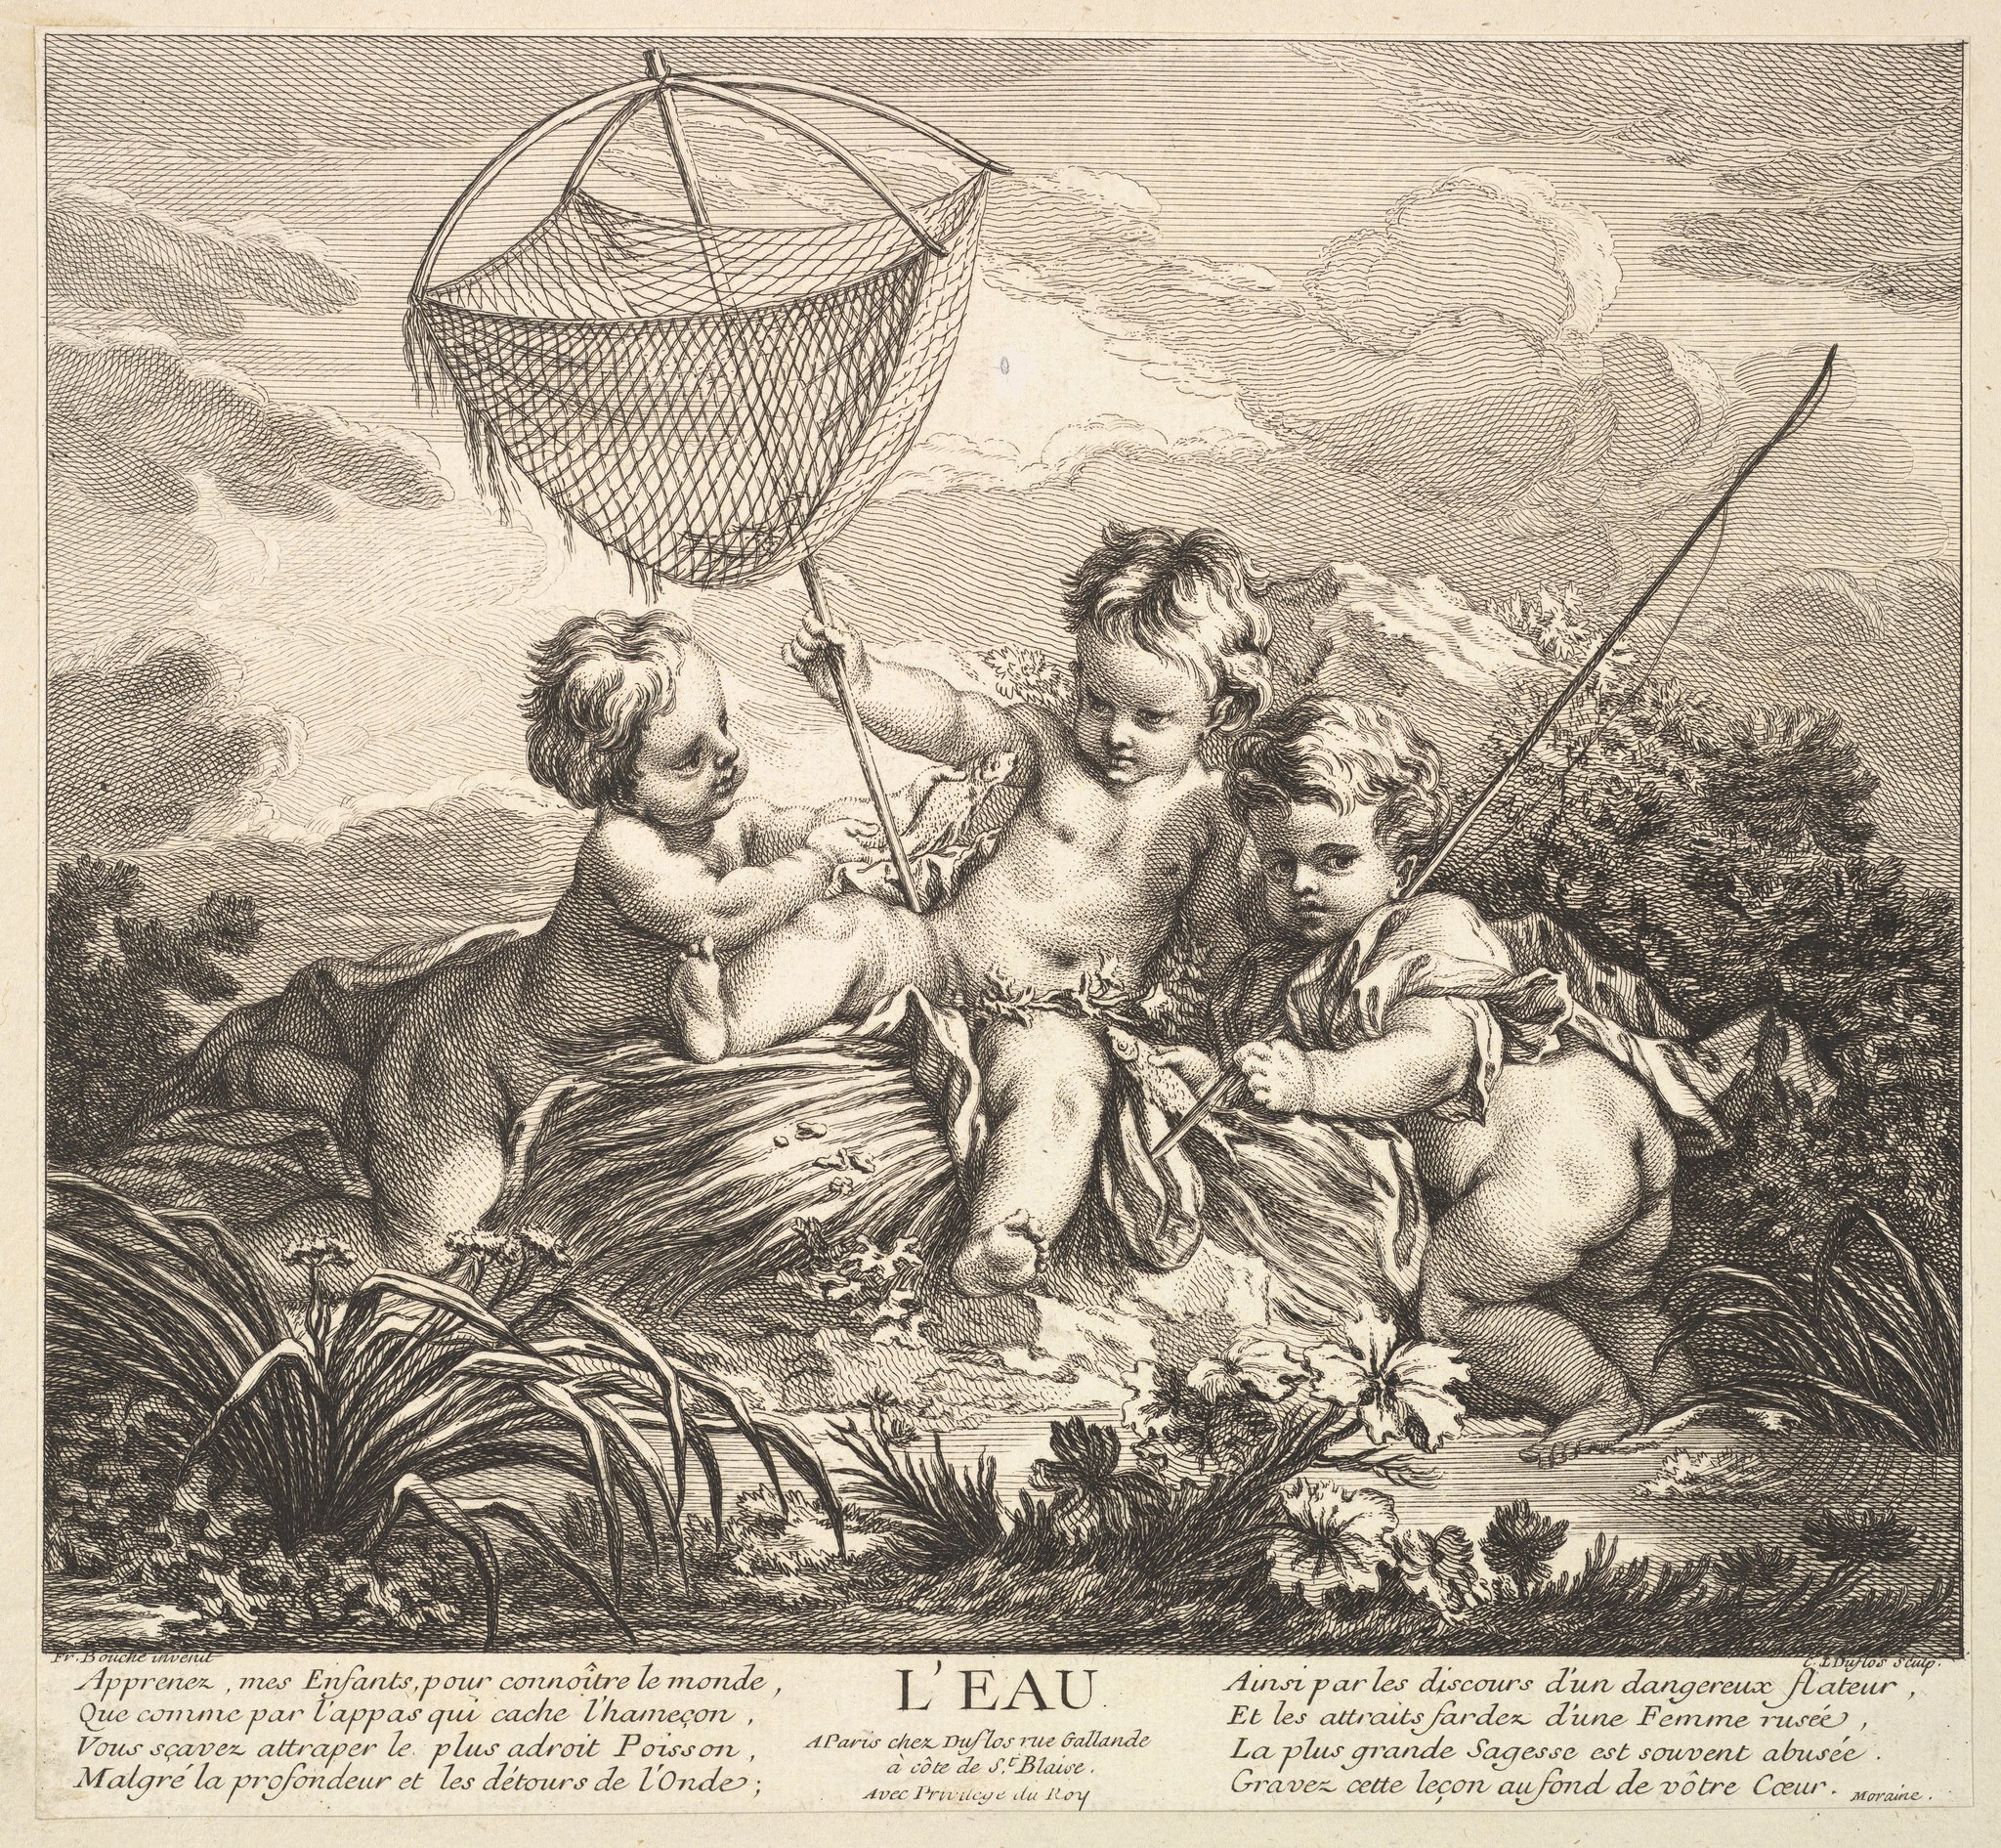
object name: print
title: Water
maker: claude augustin duflos le jeune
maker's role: artist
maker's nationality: french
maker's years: 1700-1786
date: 1701-1800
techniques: engraving, etching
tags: children,fishing,fish